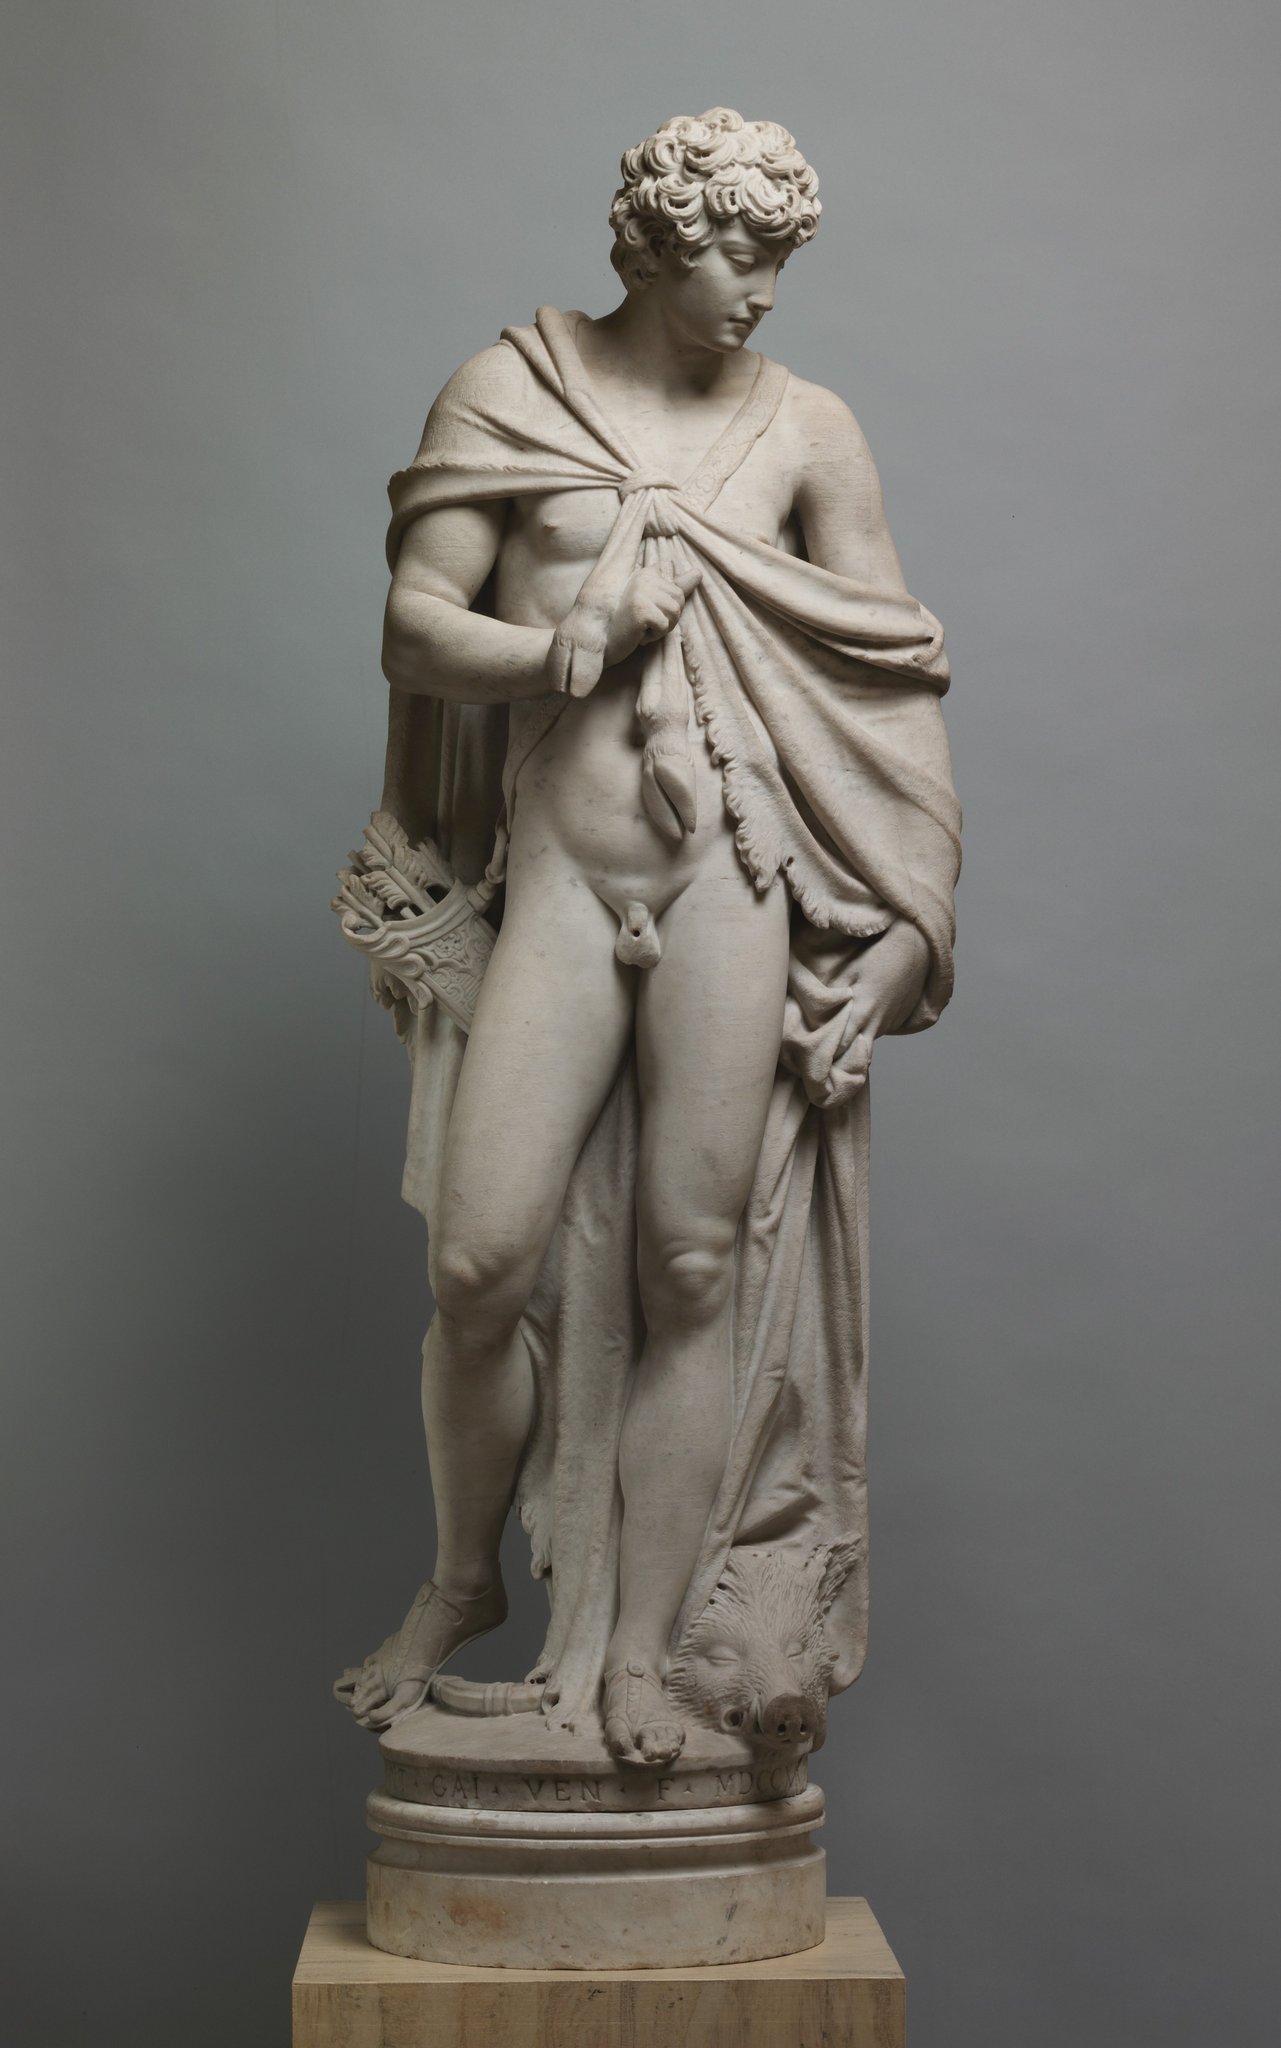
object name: statue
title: Meleager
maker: antonio gai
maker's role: artist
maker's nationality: italian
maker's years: 1686-1769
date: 1735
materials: marble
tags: male nudes,boars